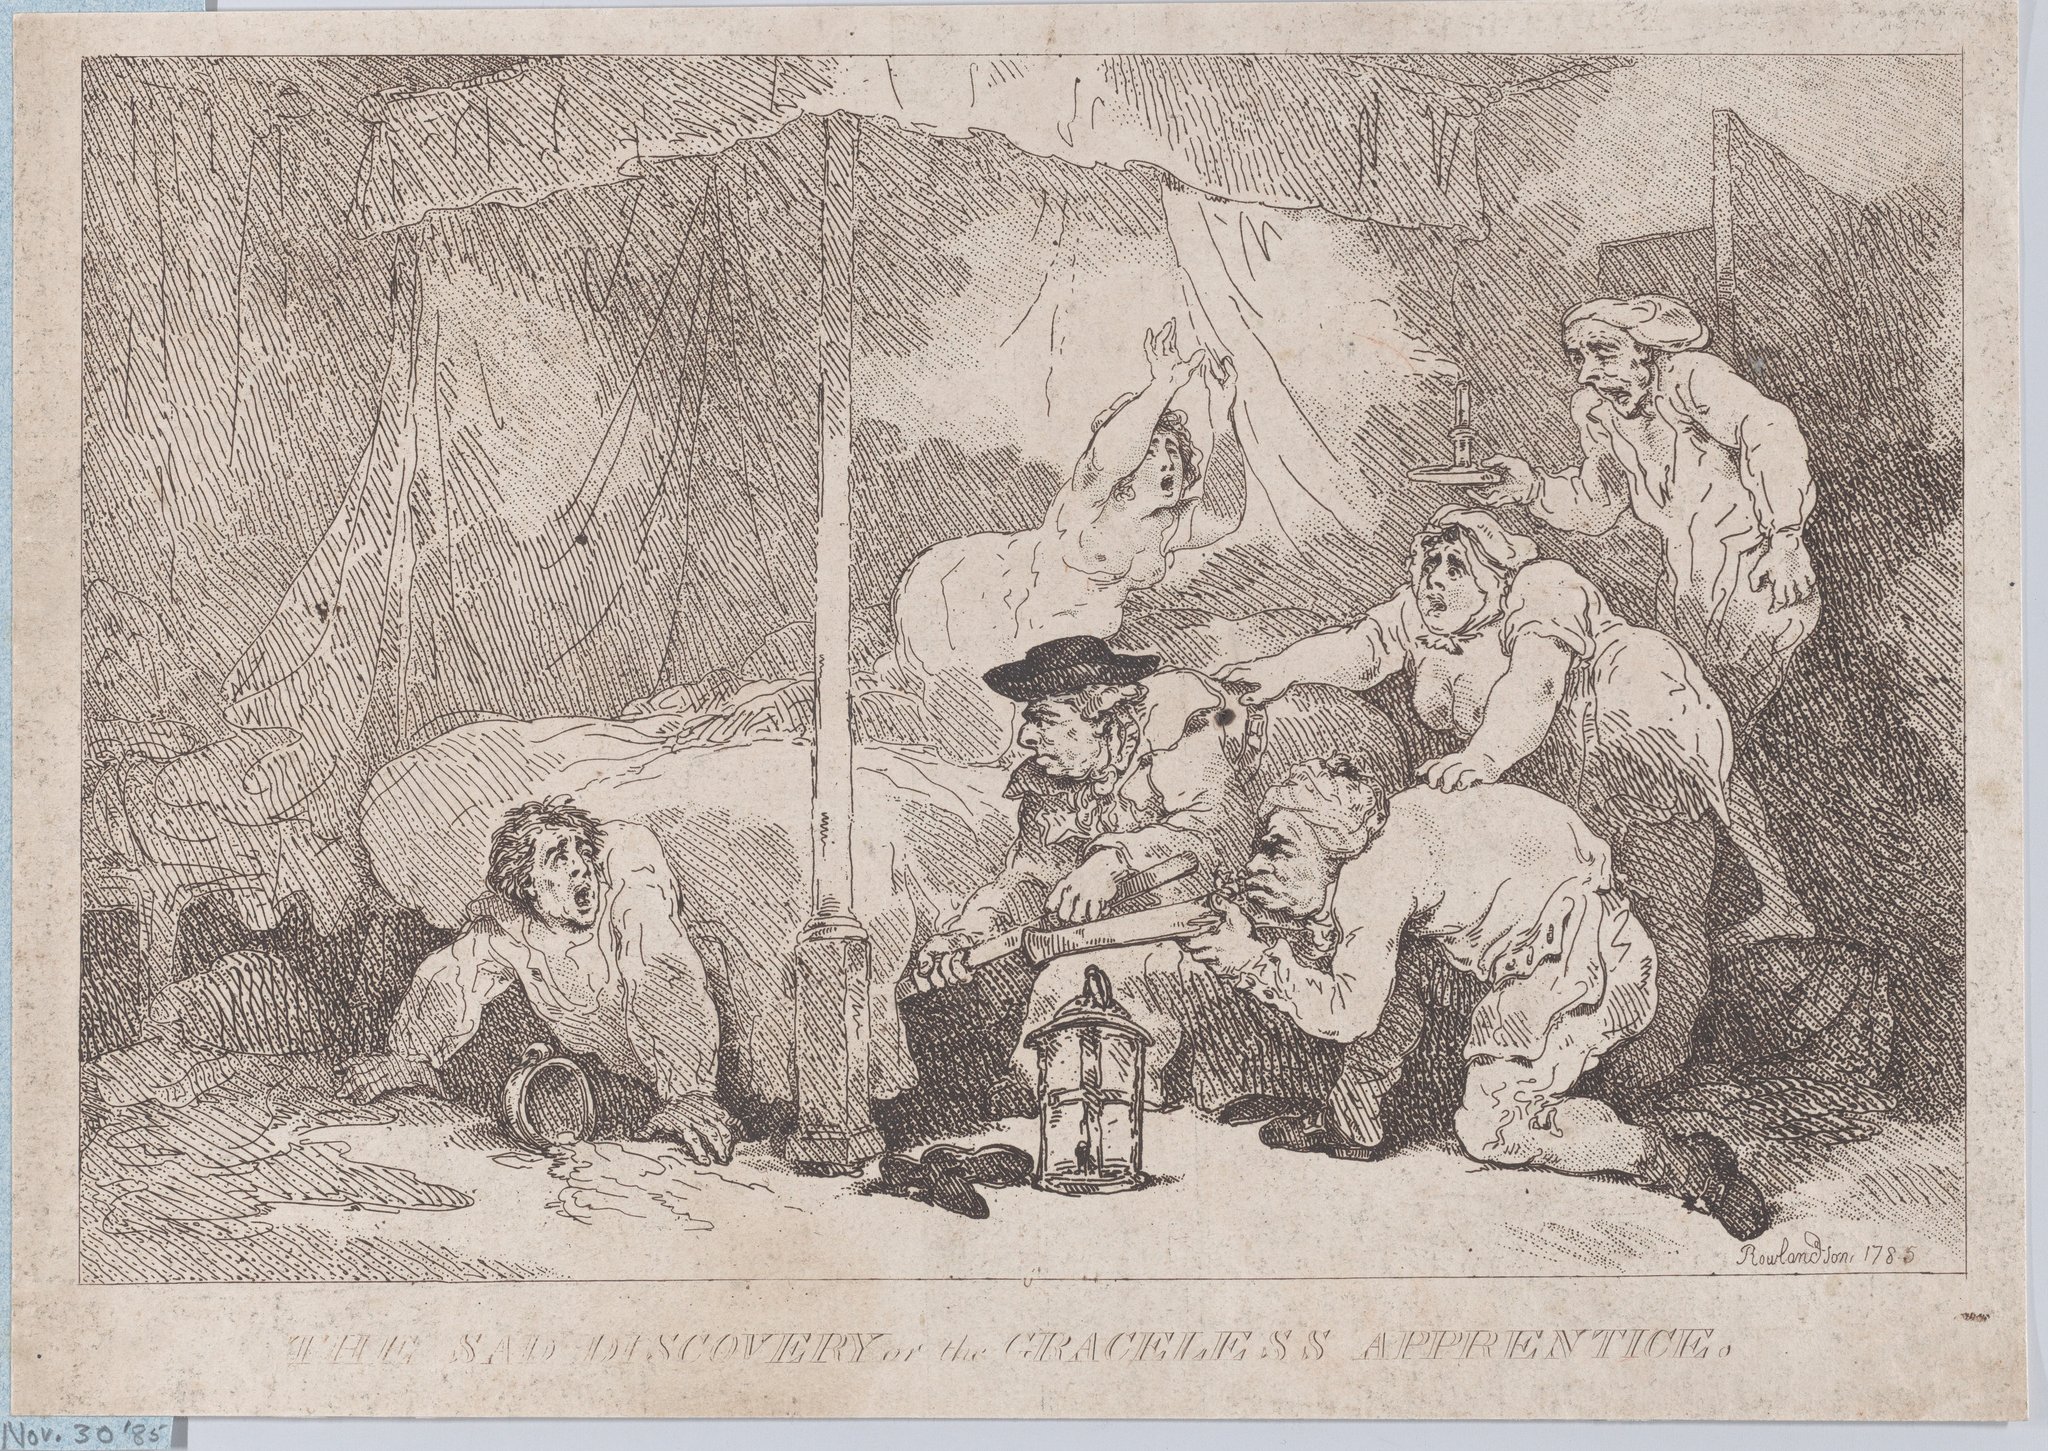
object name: print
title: The Sad Discovery of the Graceless Apprentice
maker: thomas rowlandson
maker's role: artist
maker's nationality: british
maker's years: 1757-1827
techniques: etching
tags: satire,bedrooms,men,women,beds